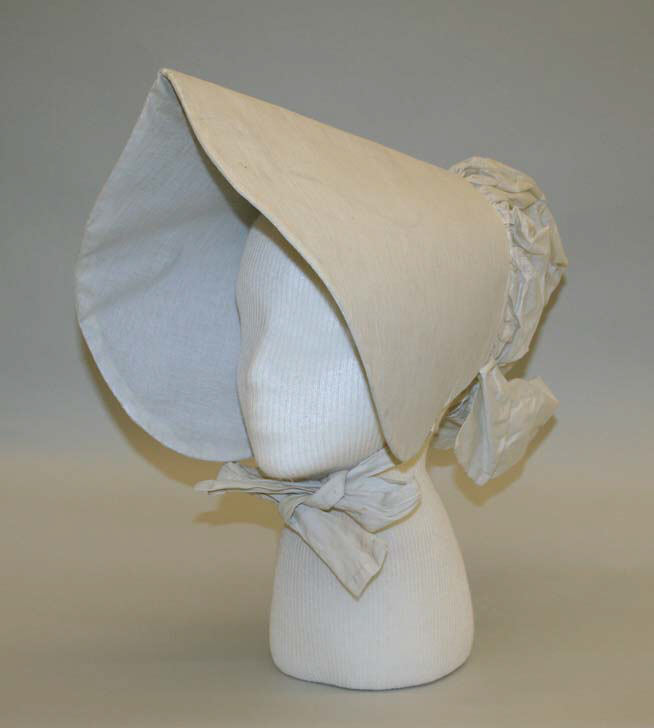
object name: sunbonnet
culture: american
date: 1850-1900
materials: cotton, linen